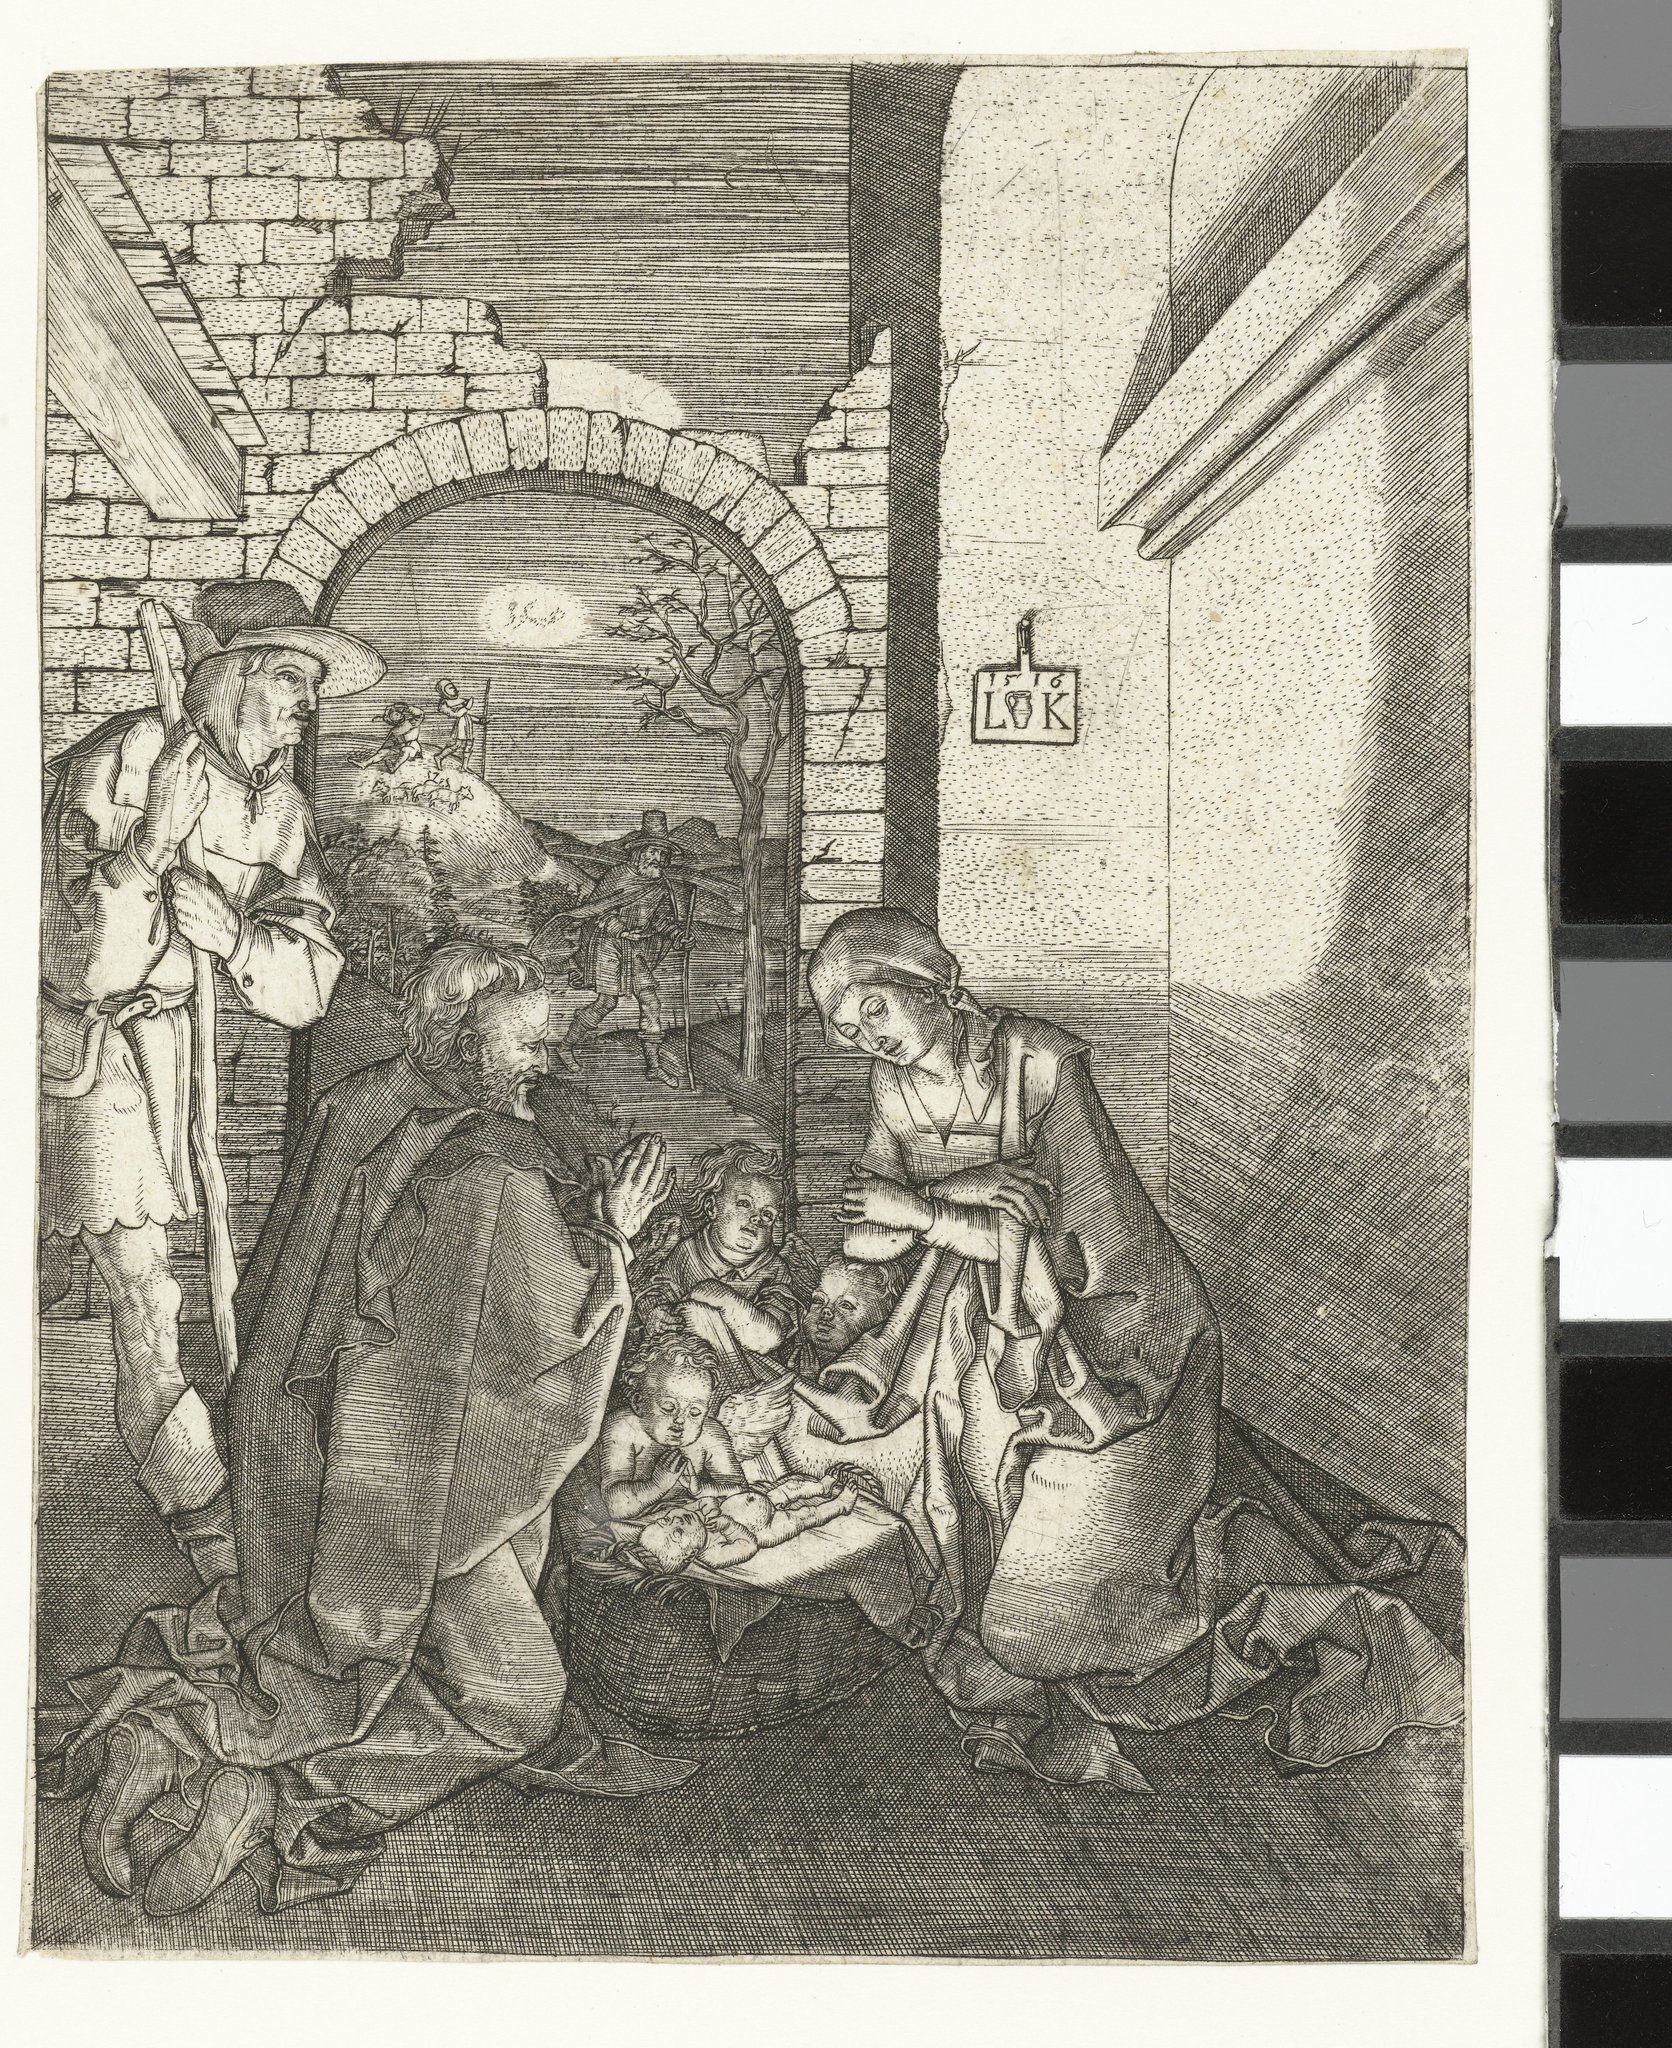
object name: print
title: Geboorte van Christus en aankondiging aan herders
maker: ludwig krug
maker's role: print maker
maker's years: 1488-1532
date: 1516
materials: paper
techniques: engraving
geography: nuremberg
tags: annunciation of christ's birth to the shepherds (and/or shepherdesses) at night; a host of singing angels in the air, mary, joseph and the new-born christ (nativity)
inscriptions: collector's mark: Lugt 2228a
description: Maria en Jozef knielen bij de kribbe met de pasgeboren Christus. Drie kleine engelen kijken naar het kind en een herder bewijst zijn eer. Heel klein op de achtergrond vindt de aankondiging aan de herders plaats.